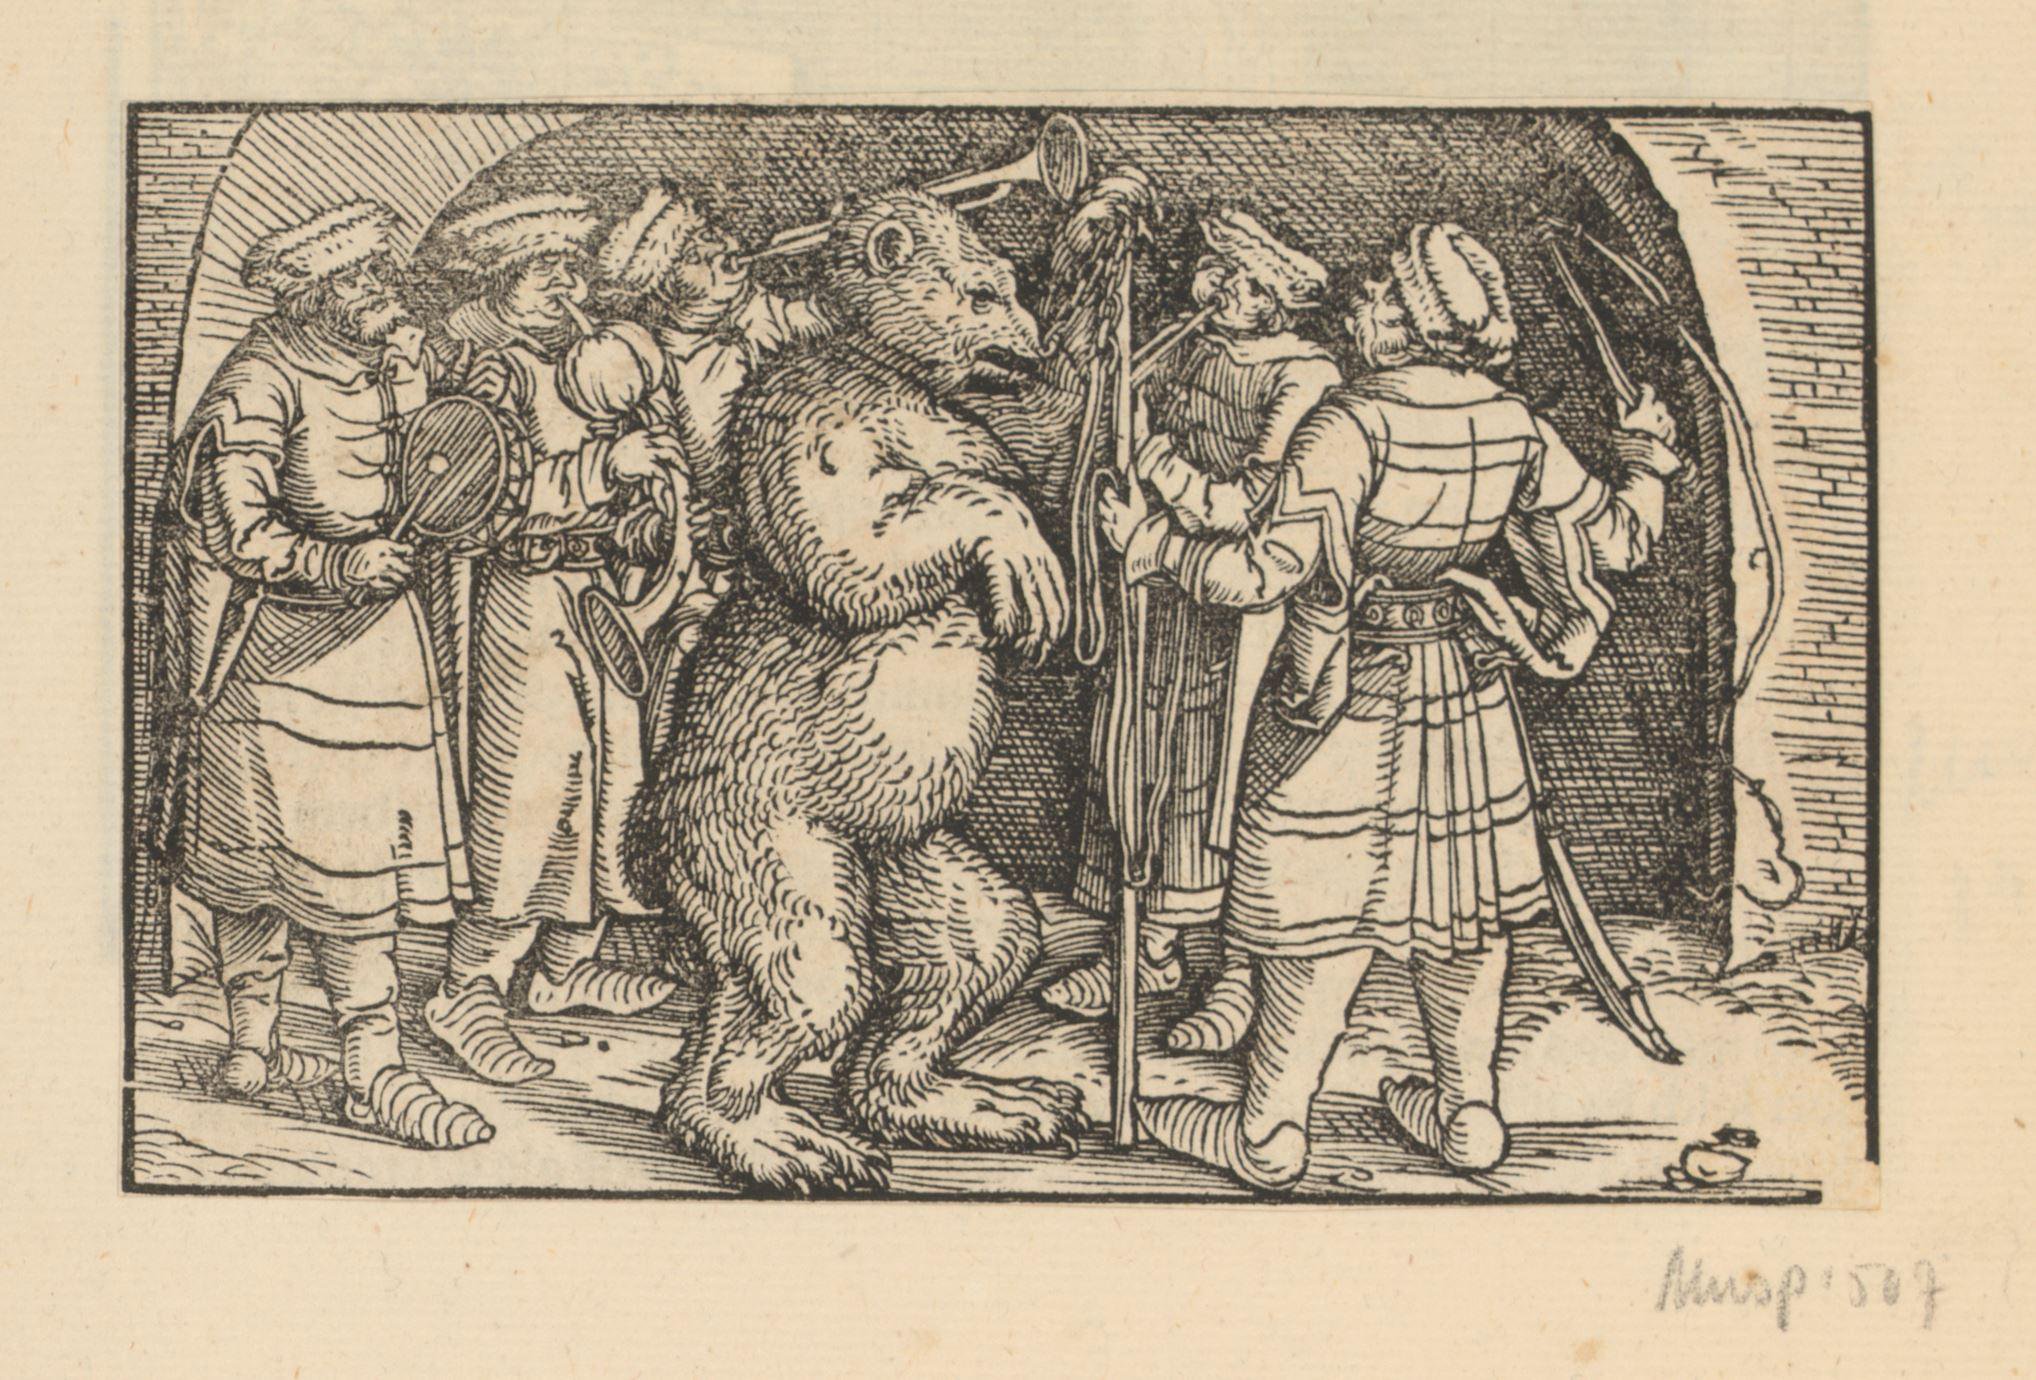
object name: book illustration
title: Dansende beer begeleid door een musicerend gezelschap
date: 1514-1531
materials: paper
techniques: letterpress printing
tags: beasts of prey, predatory animals: bear, performance in the open air (pleasure fair)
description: Deze prent is gebruikt in: Cicero, Marcus Tulius. Officia M.T.C. Ein Buch so Marcus Tullius Cicero der Römer zu seynem (...). [Vertaald uit het Latijn door] Johann von Schwarzenberg. Augsburg: Heinrich Steiner, 1531.